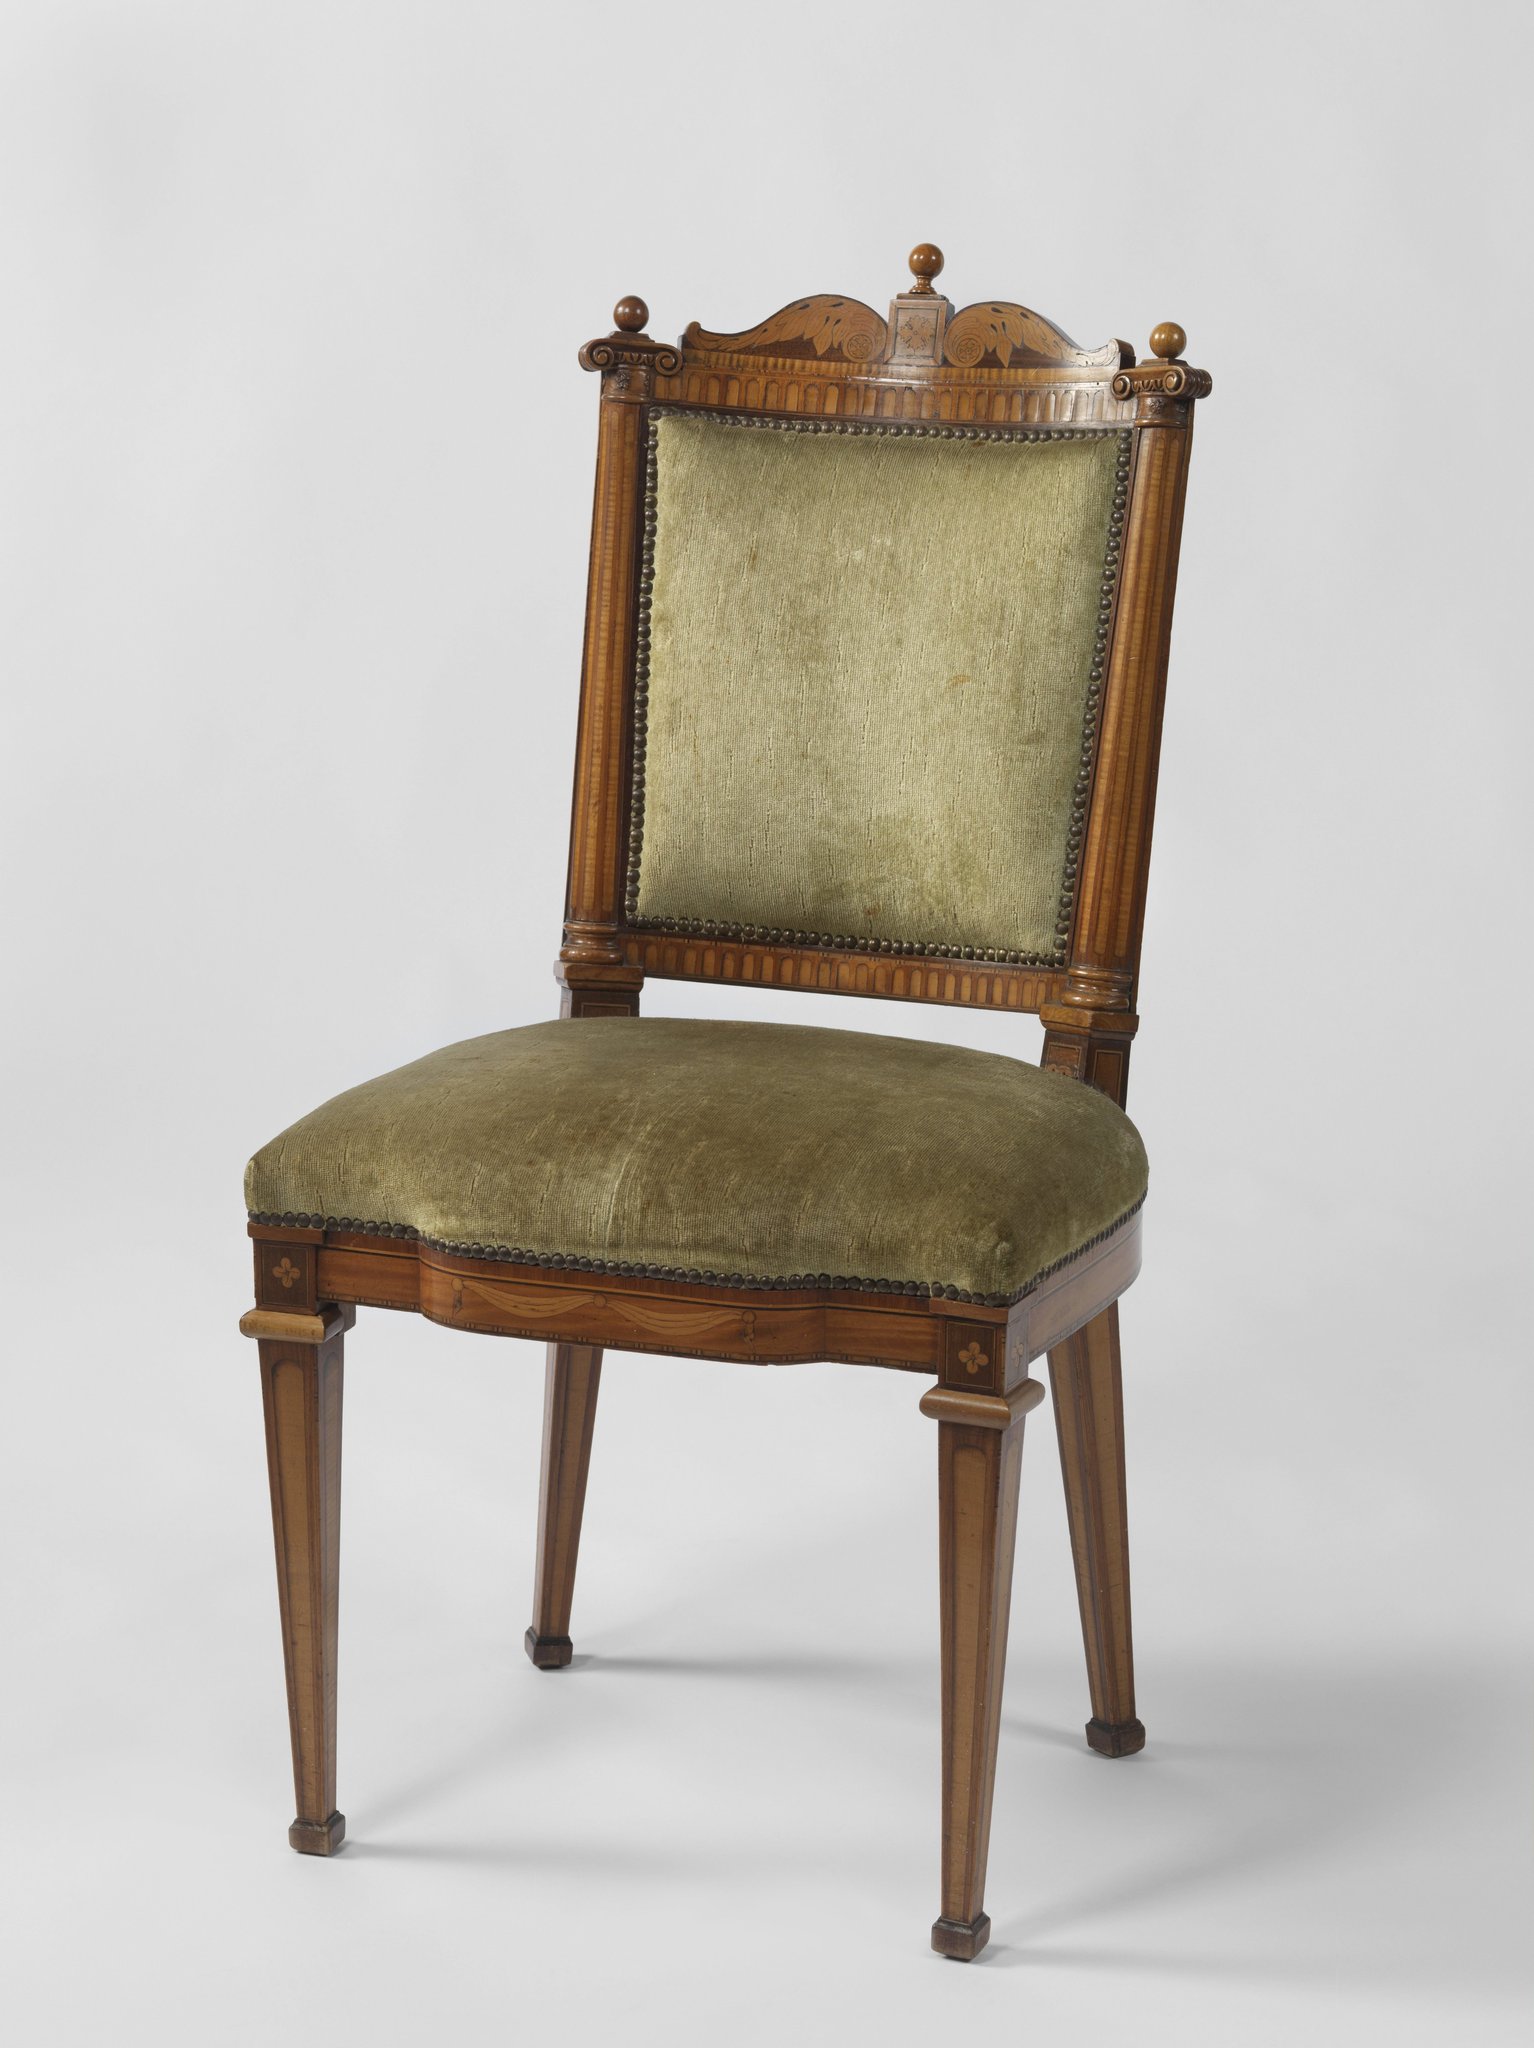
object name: seating furniture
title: Four chairs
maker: Anonymous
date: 1780-1790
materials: wood, textile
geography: netherlands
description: The shape of these chairs was common in the Neoclassical period in the Netherlands. At that time, it was usual for the decoration to be carved on the chair. In the case of these four chairs, however, the decoration is carried out in marquetry. This suggests that they were not made by a chairmaker, but rather by a cabinetmaker, who usually made cabinets, commodes and other such furniture.